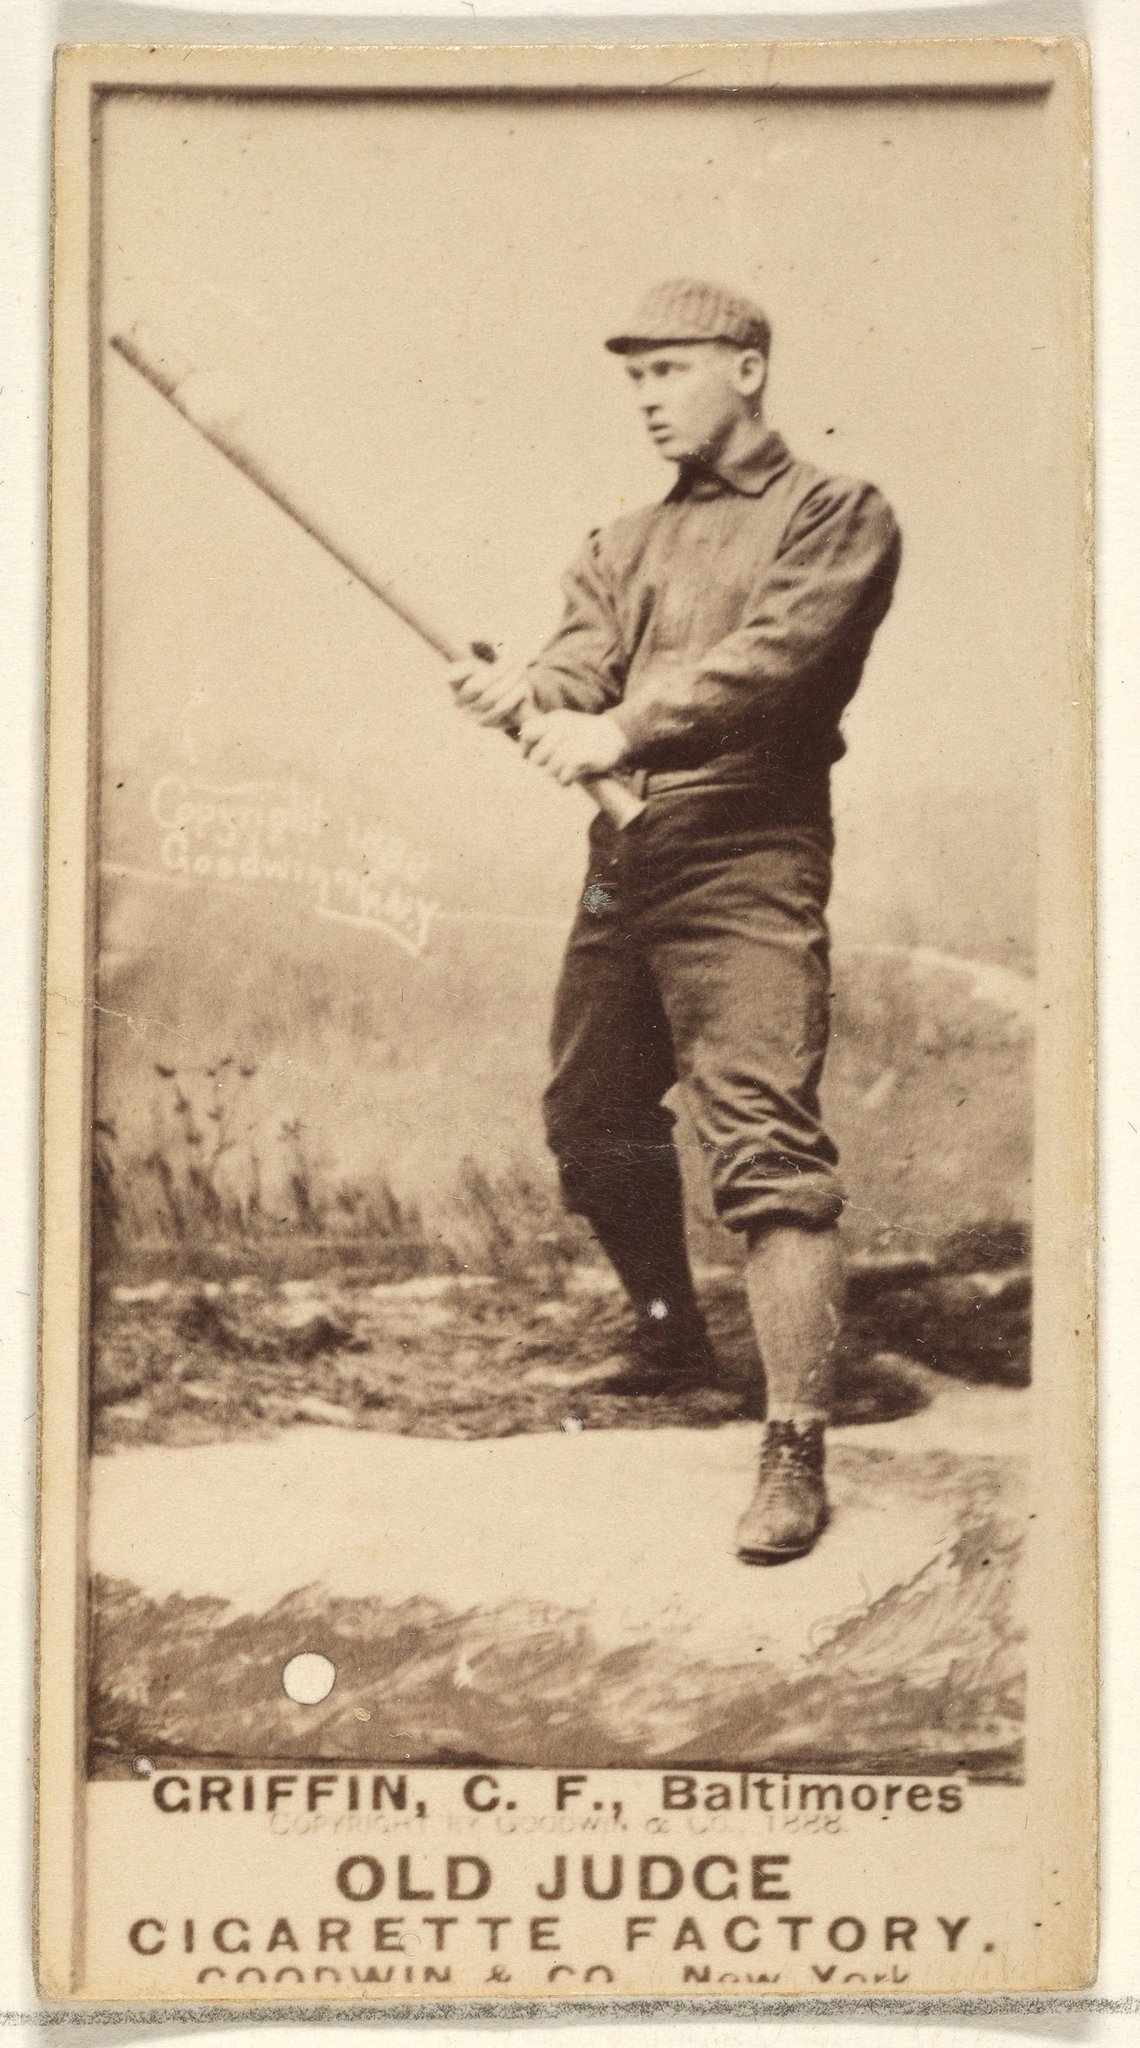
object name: baseball card, photograph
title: Griffin, Center Field, Baltimore Orioles, from the Old Judge series (N172) for Old Judge Cigarettes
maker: goodwin & company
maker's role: publisher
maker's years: 1850-1950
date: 1888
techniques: albumen silver print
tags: men,portraits,baseball,athletes